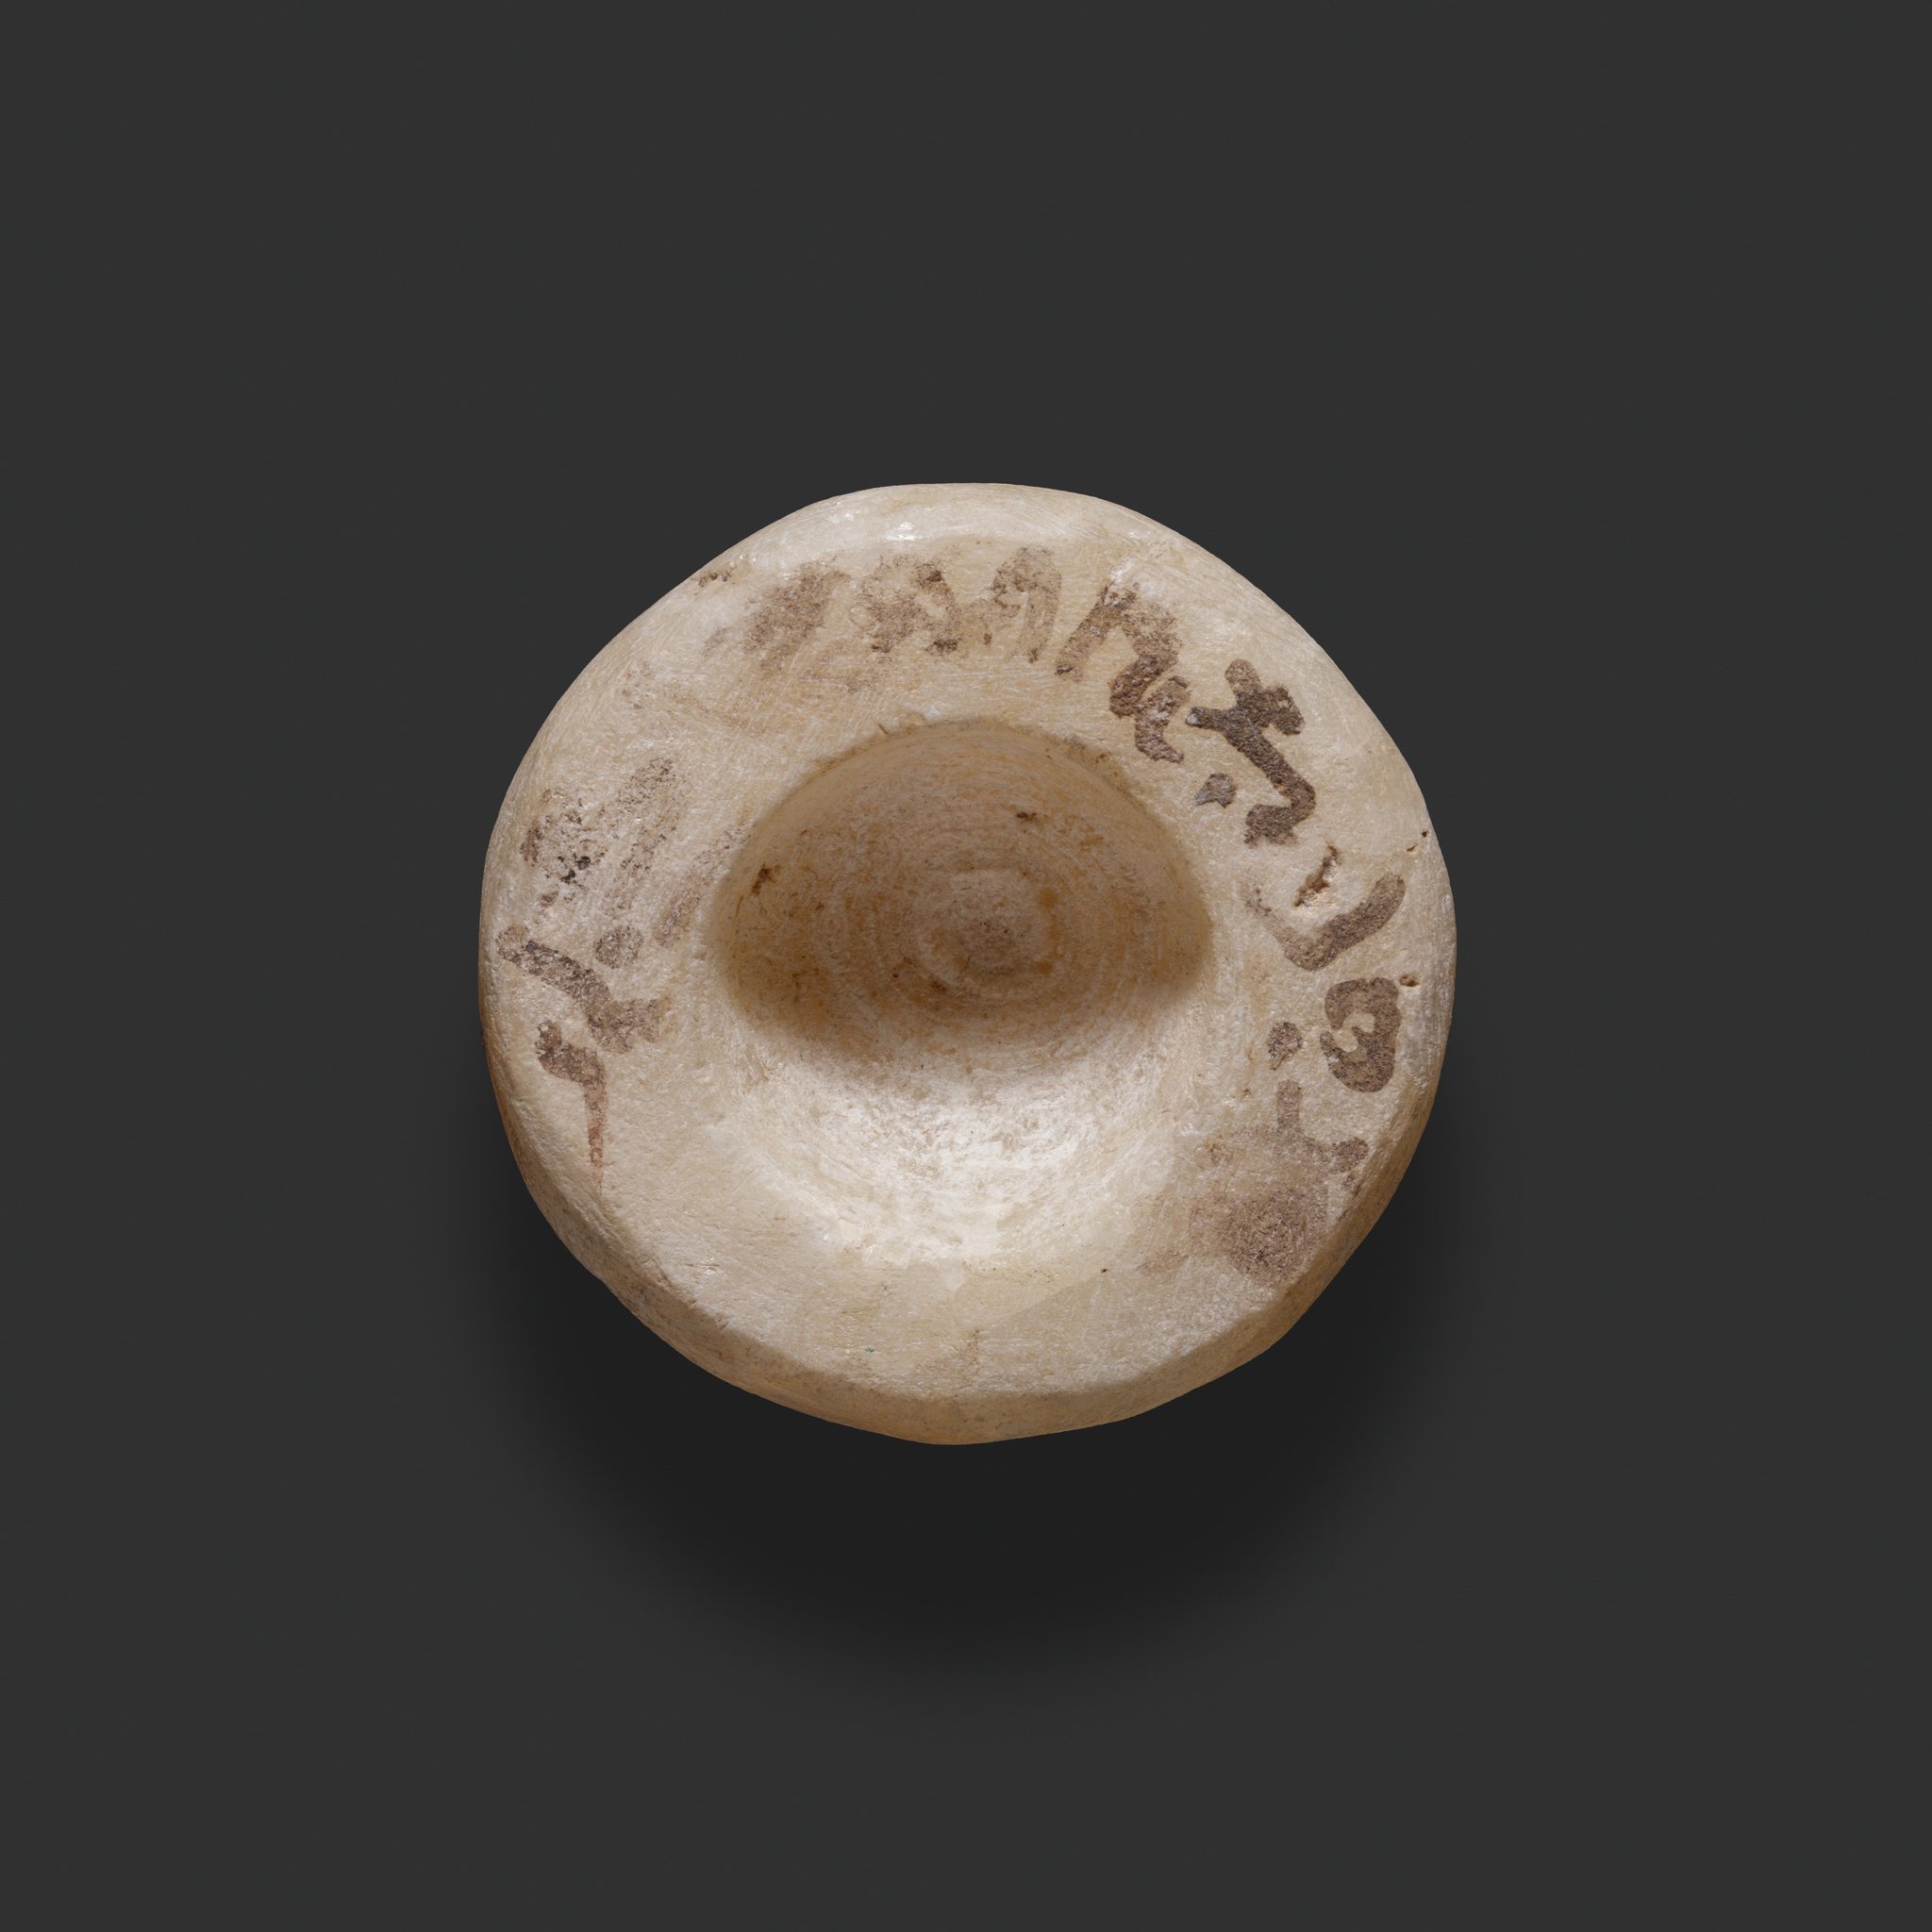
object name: model, dish, foundation deposit, hatshepsut merytre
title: Model Dish from a Foundation Depsoit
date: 1479-1425 BCE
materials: paint, stone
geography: egypt